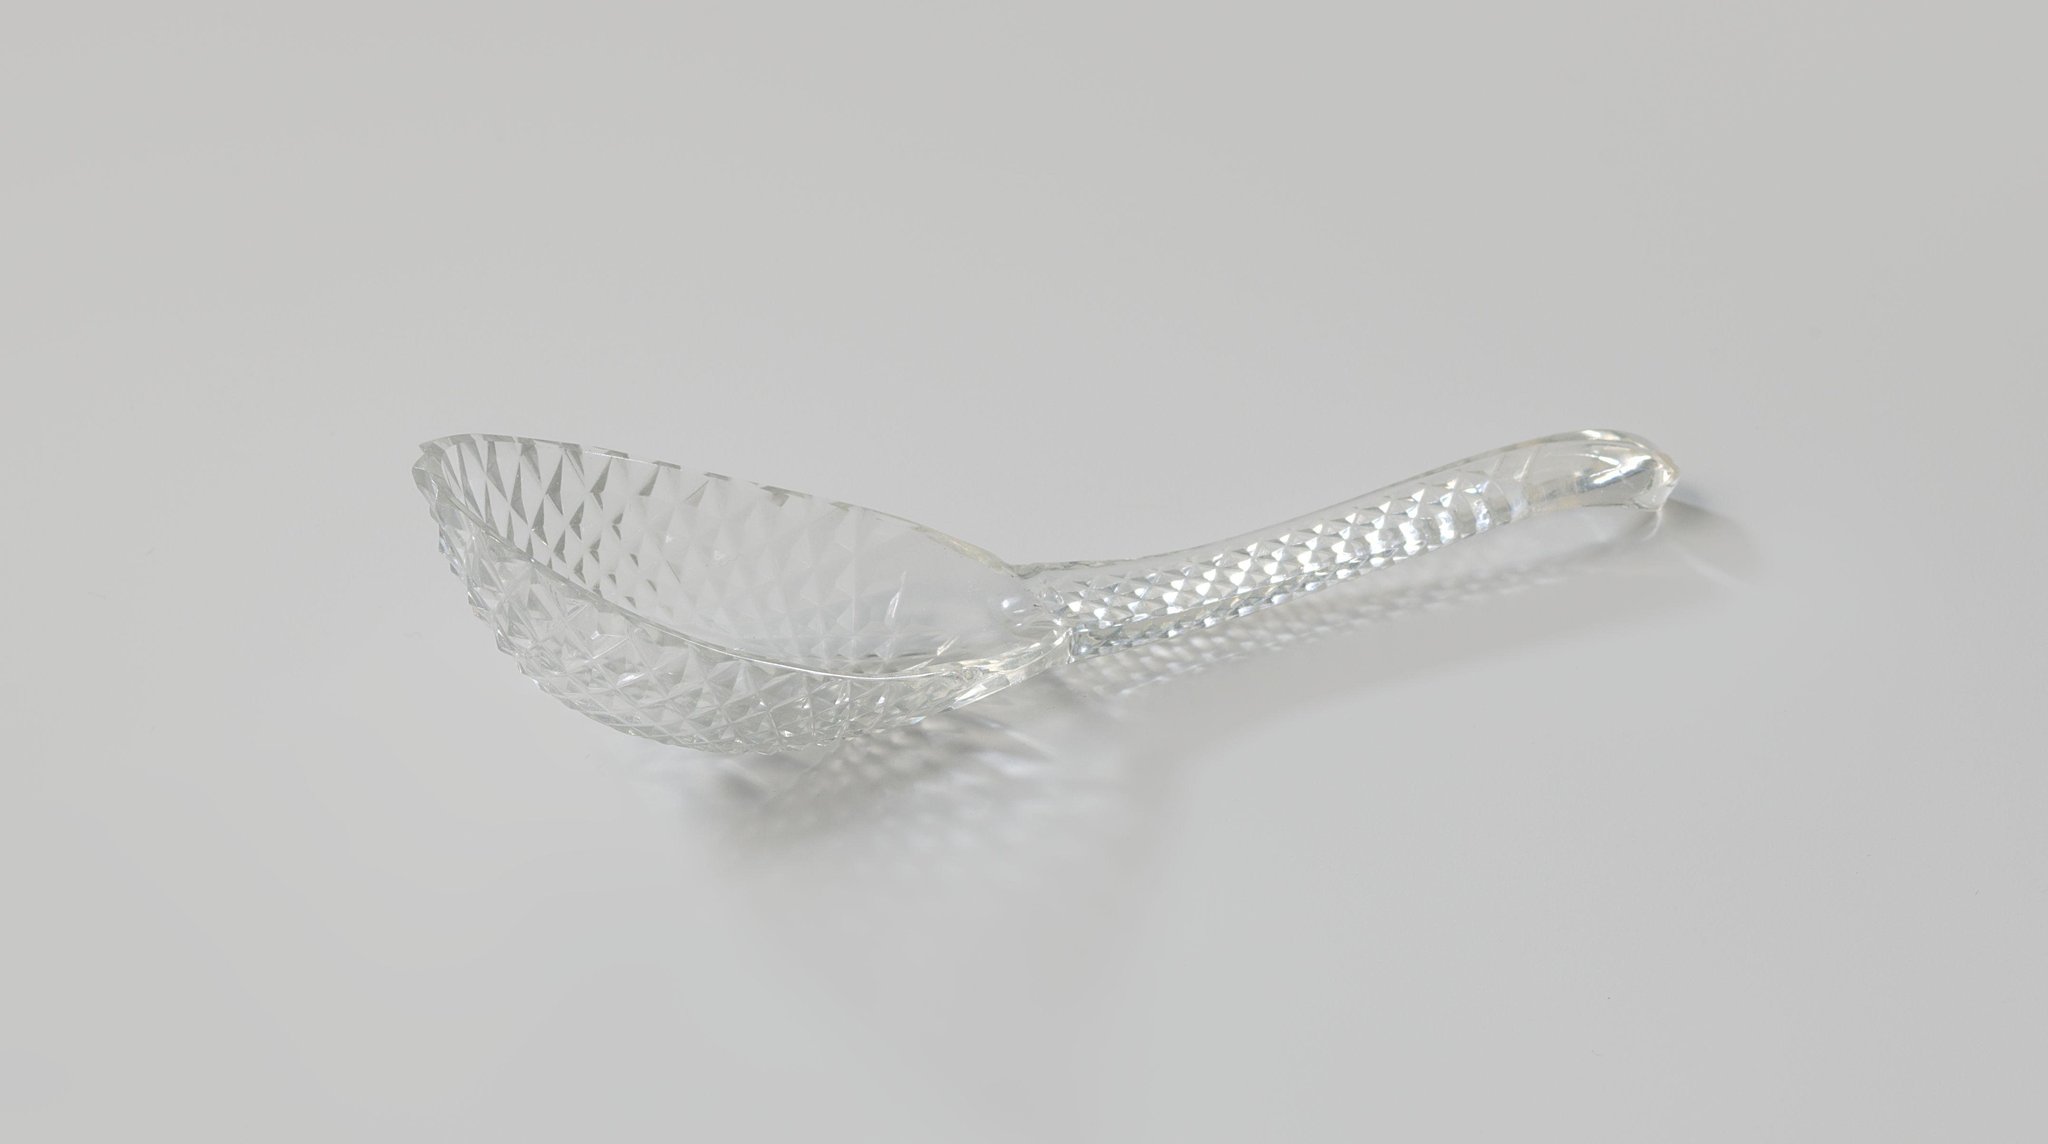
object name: spoon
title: Lepel, van zwaar glas, geslepen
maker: Anonymous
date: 1400-1950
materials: glass